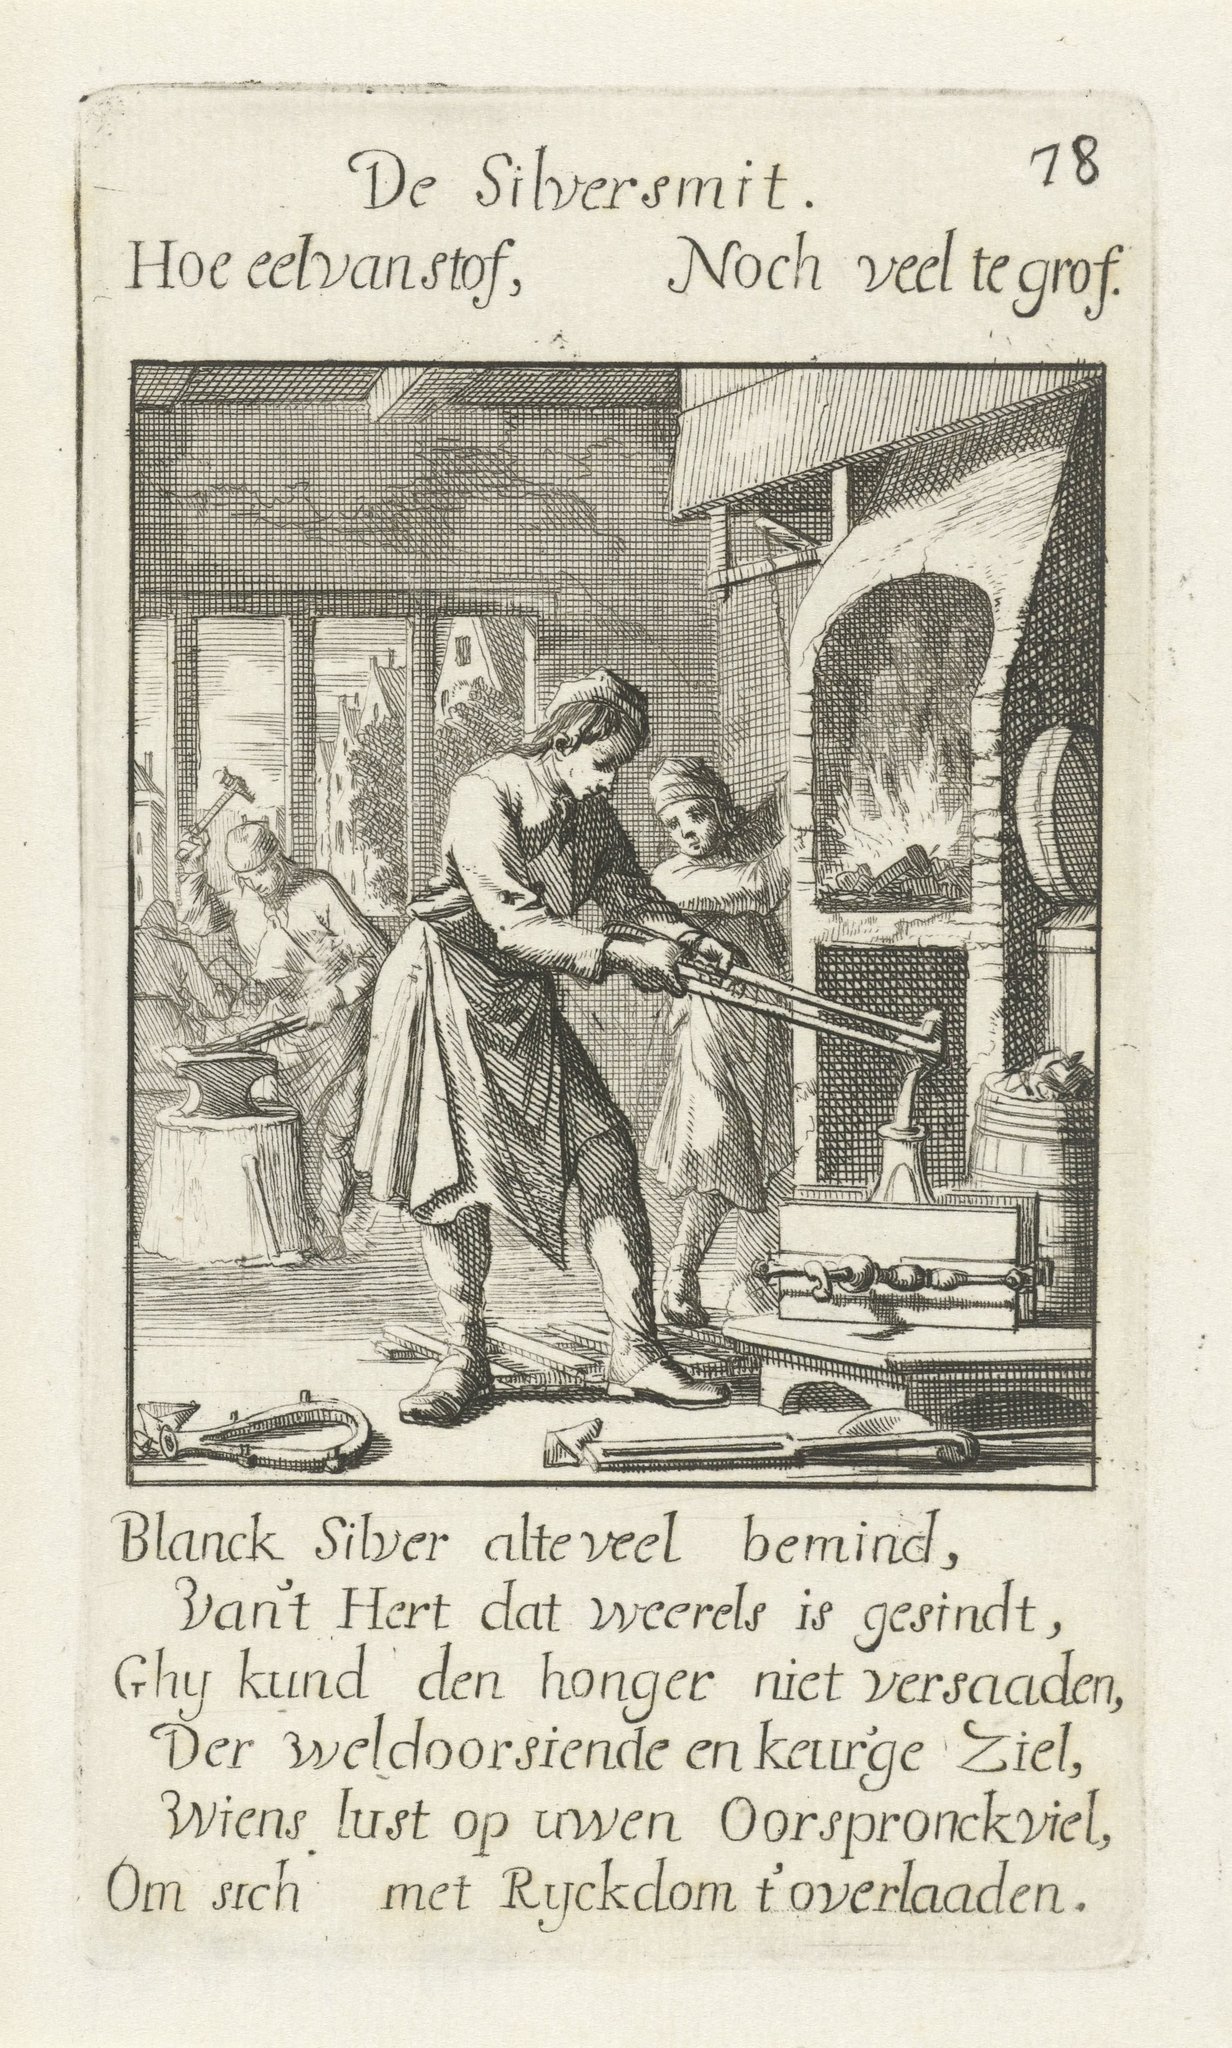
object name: print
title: Zilversmid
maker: jan luyken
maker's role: draughtsman, print maker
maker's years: 1649-1712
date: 1694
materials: paper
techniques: etching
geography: amsterdam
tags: handicrafts, craftsman at work, jeweller, goldsmith, silversmith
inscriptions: collector's mark: Lugt 2228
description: Maakt deel uit van de 100-delige serie beroepsprenten van Jan en Caspar Luyken, getiteld: Het menselyk bedryf. S.l.s.n., 1694 (eerste druk).